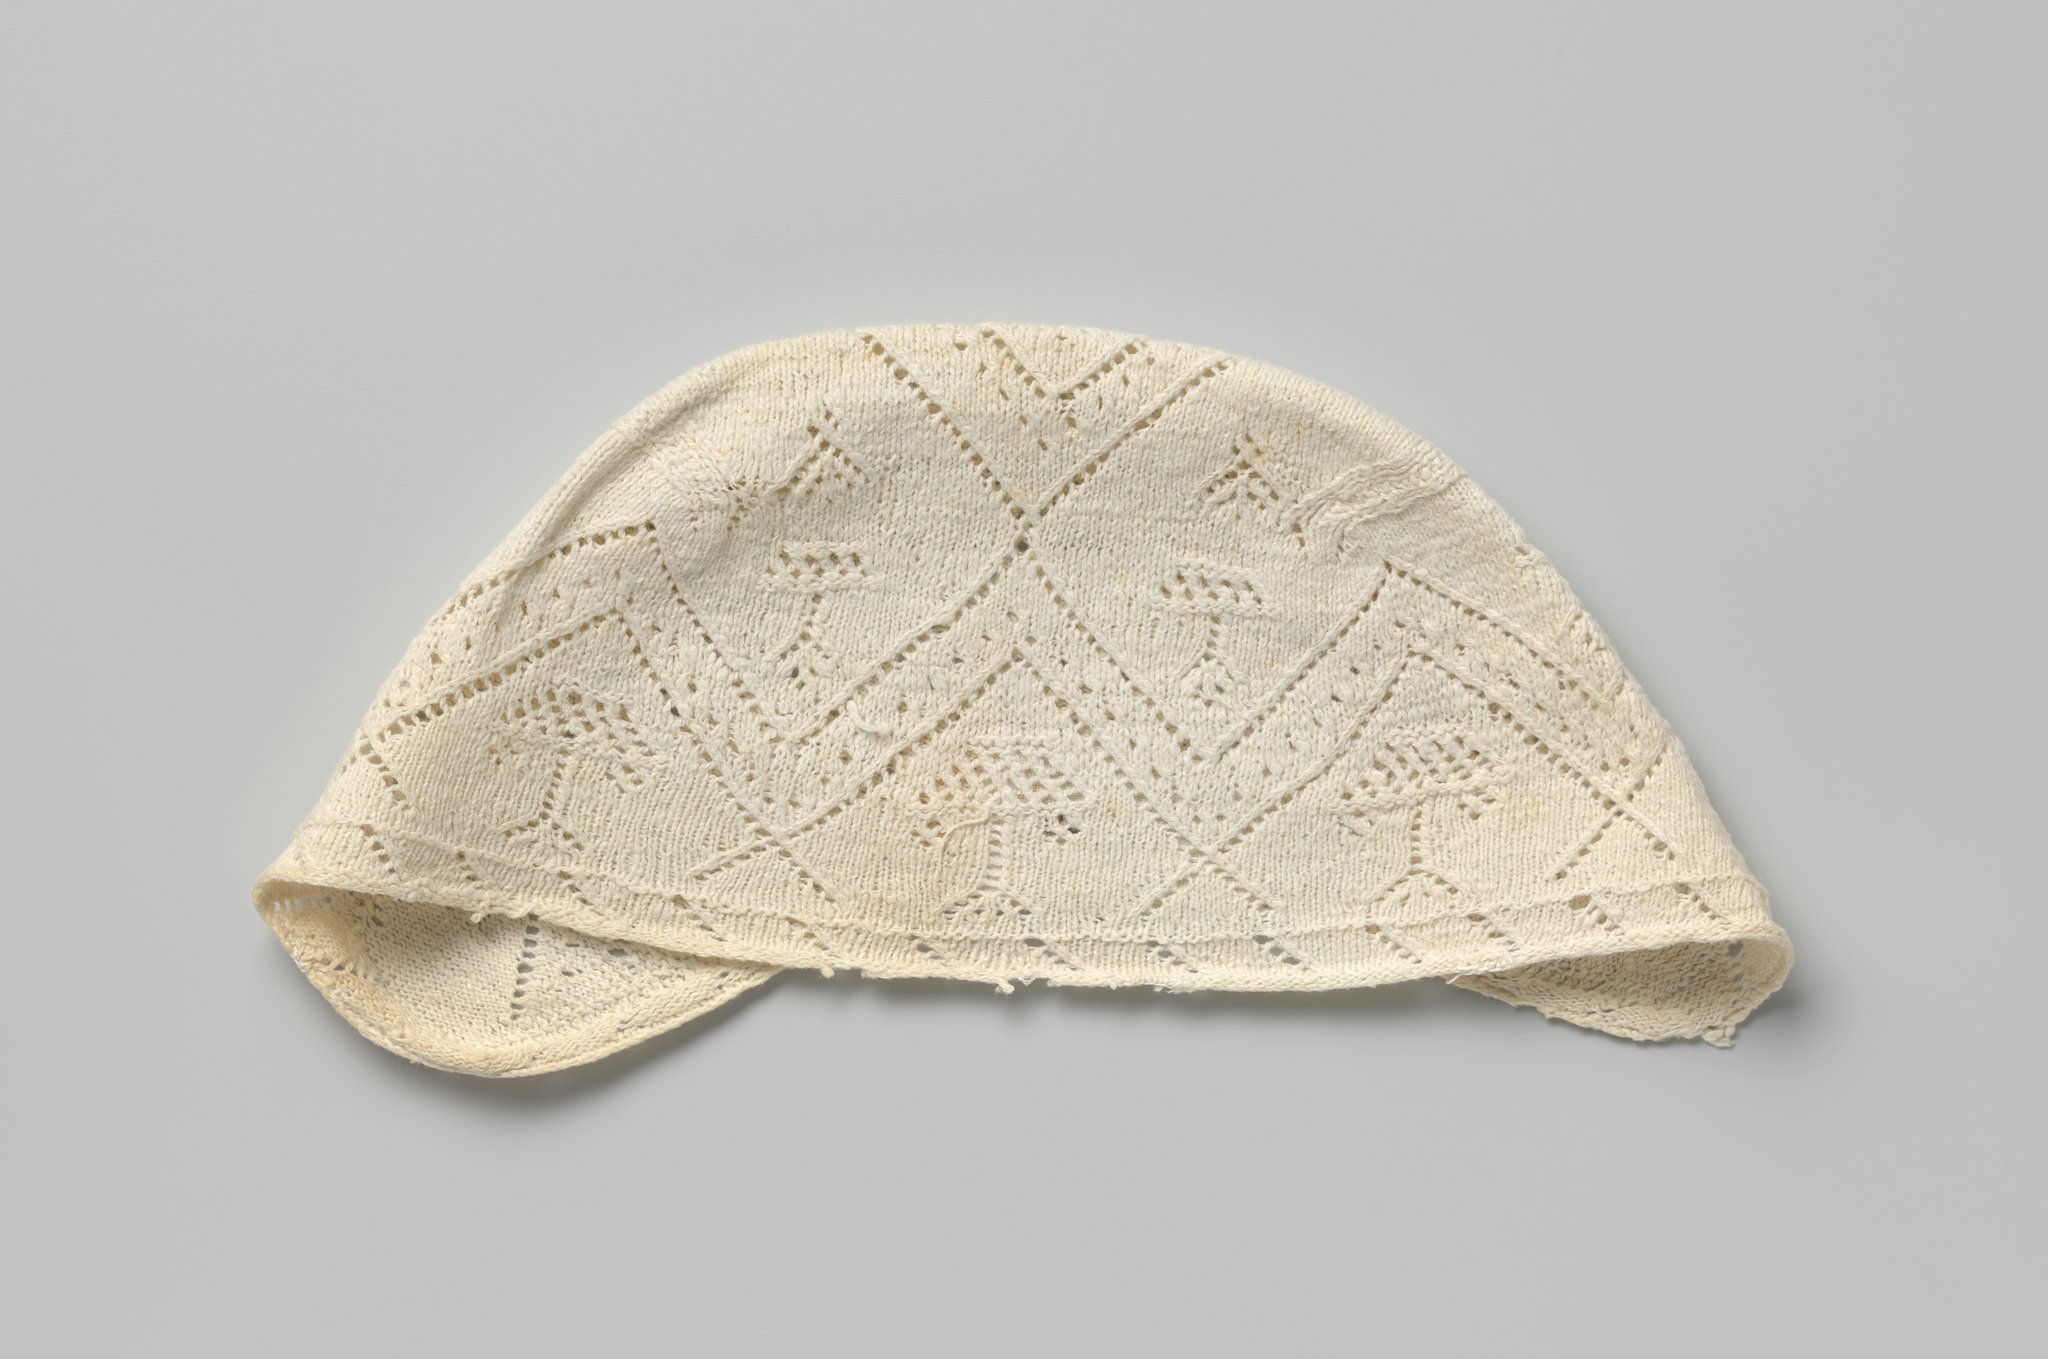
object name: cap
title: Gebreide muts van wit katoen met opengewerkte zigzagranden en een boomvormig motief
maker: Anonymous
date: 1800-1900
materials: cotton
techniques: embroidery, knitting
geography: europe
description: Gebreide muts van wit katoen met opengewerkte zigzagranden en een boomvormig motief.